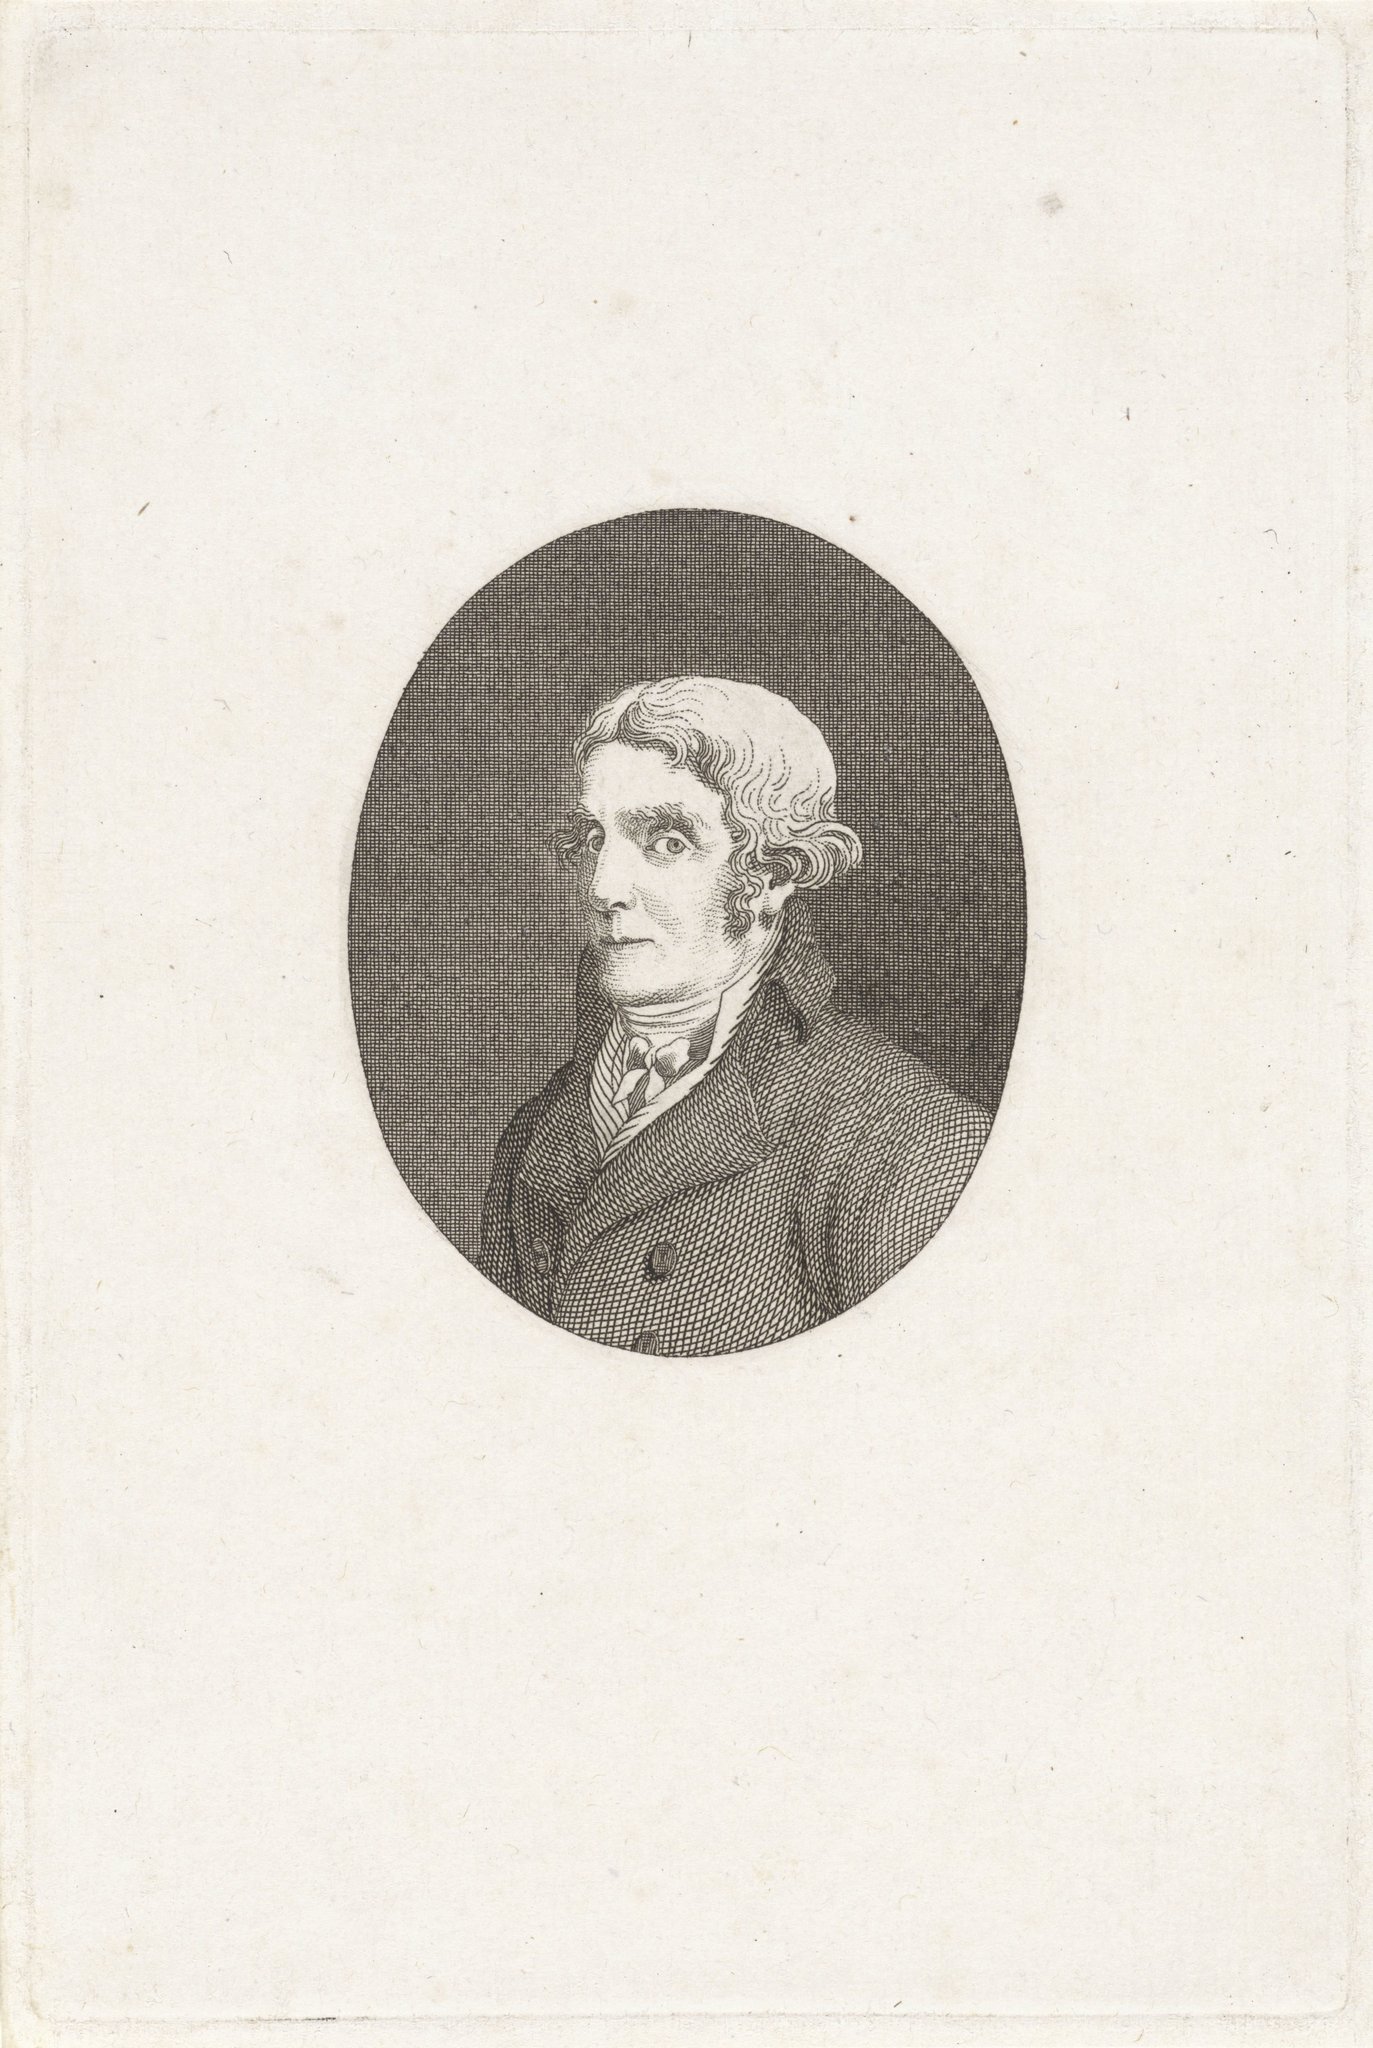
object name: print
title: Portret van Izaak Jansz. de Wit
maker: joannes pieter visser bender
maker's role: draughtsman, print maker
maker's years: 1785-1813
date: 1809-1813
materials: paper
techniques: etching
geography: haarlem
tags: amsterdam, print maker, draughtsman, publisher, izaak jansz. de wit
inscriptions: collector's mark: Lugt 2228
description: Portret van de Nederlandse prentmaker Izaak Jansz. de Wit.